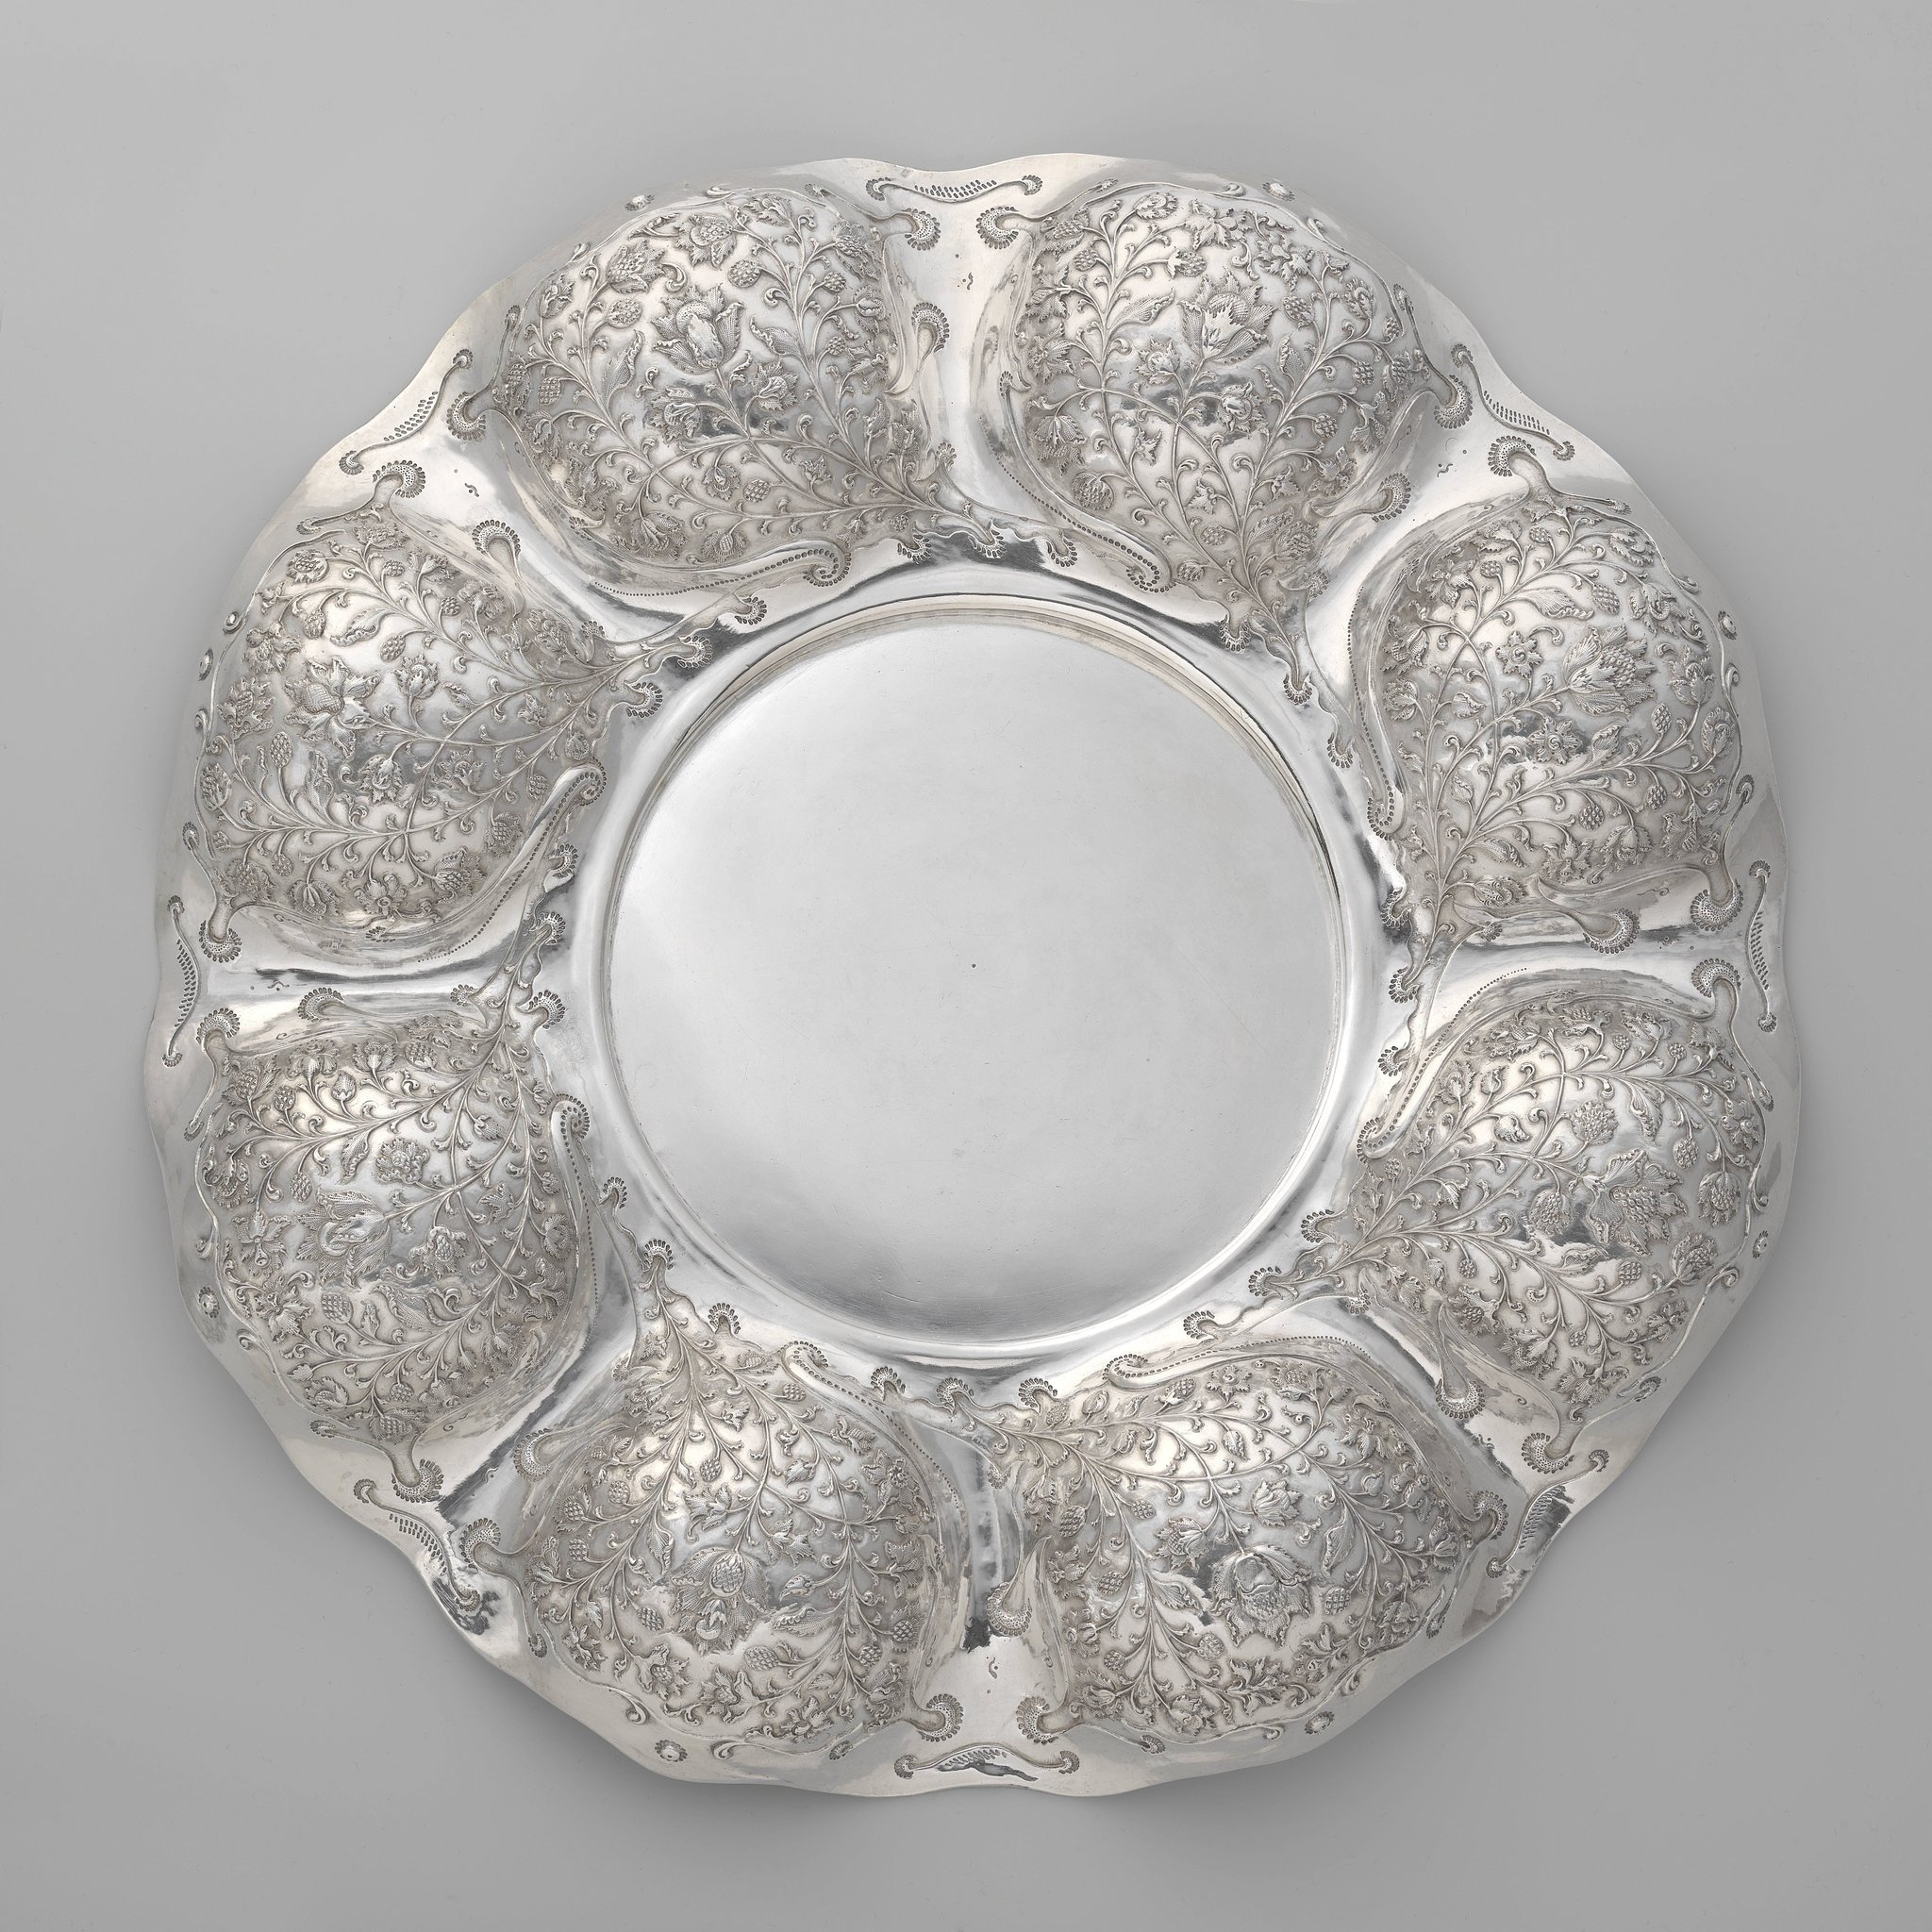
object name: dish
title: Schaal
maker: Anonymous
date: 1650-1700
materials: silver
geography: jakarta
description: Dish. Silver. Batavia, 1650 - 1700.